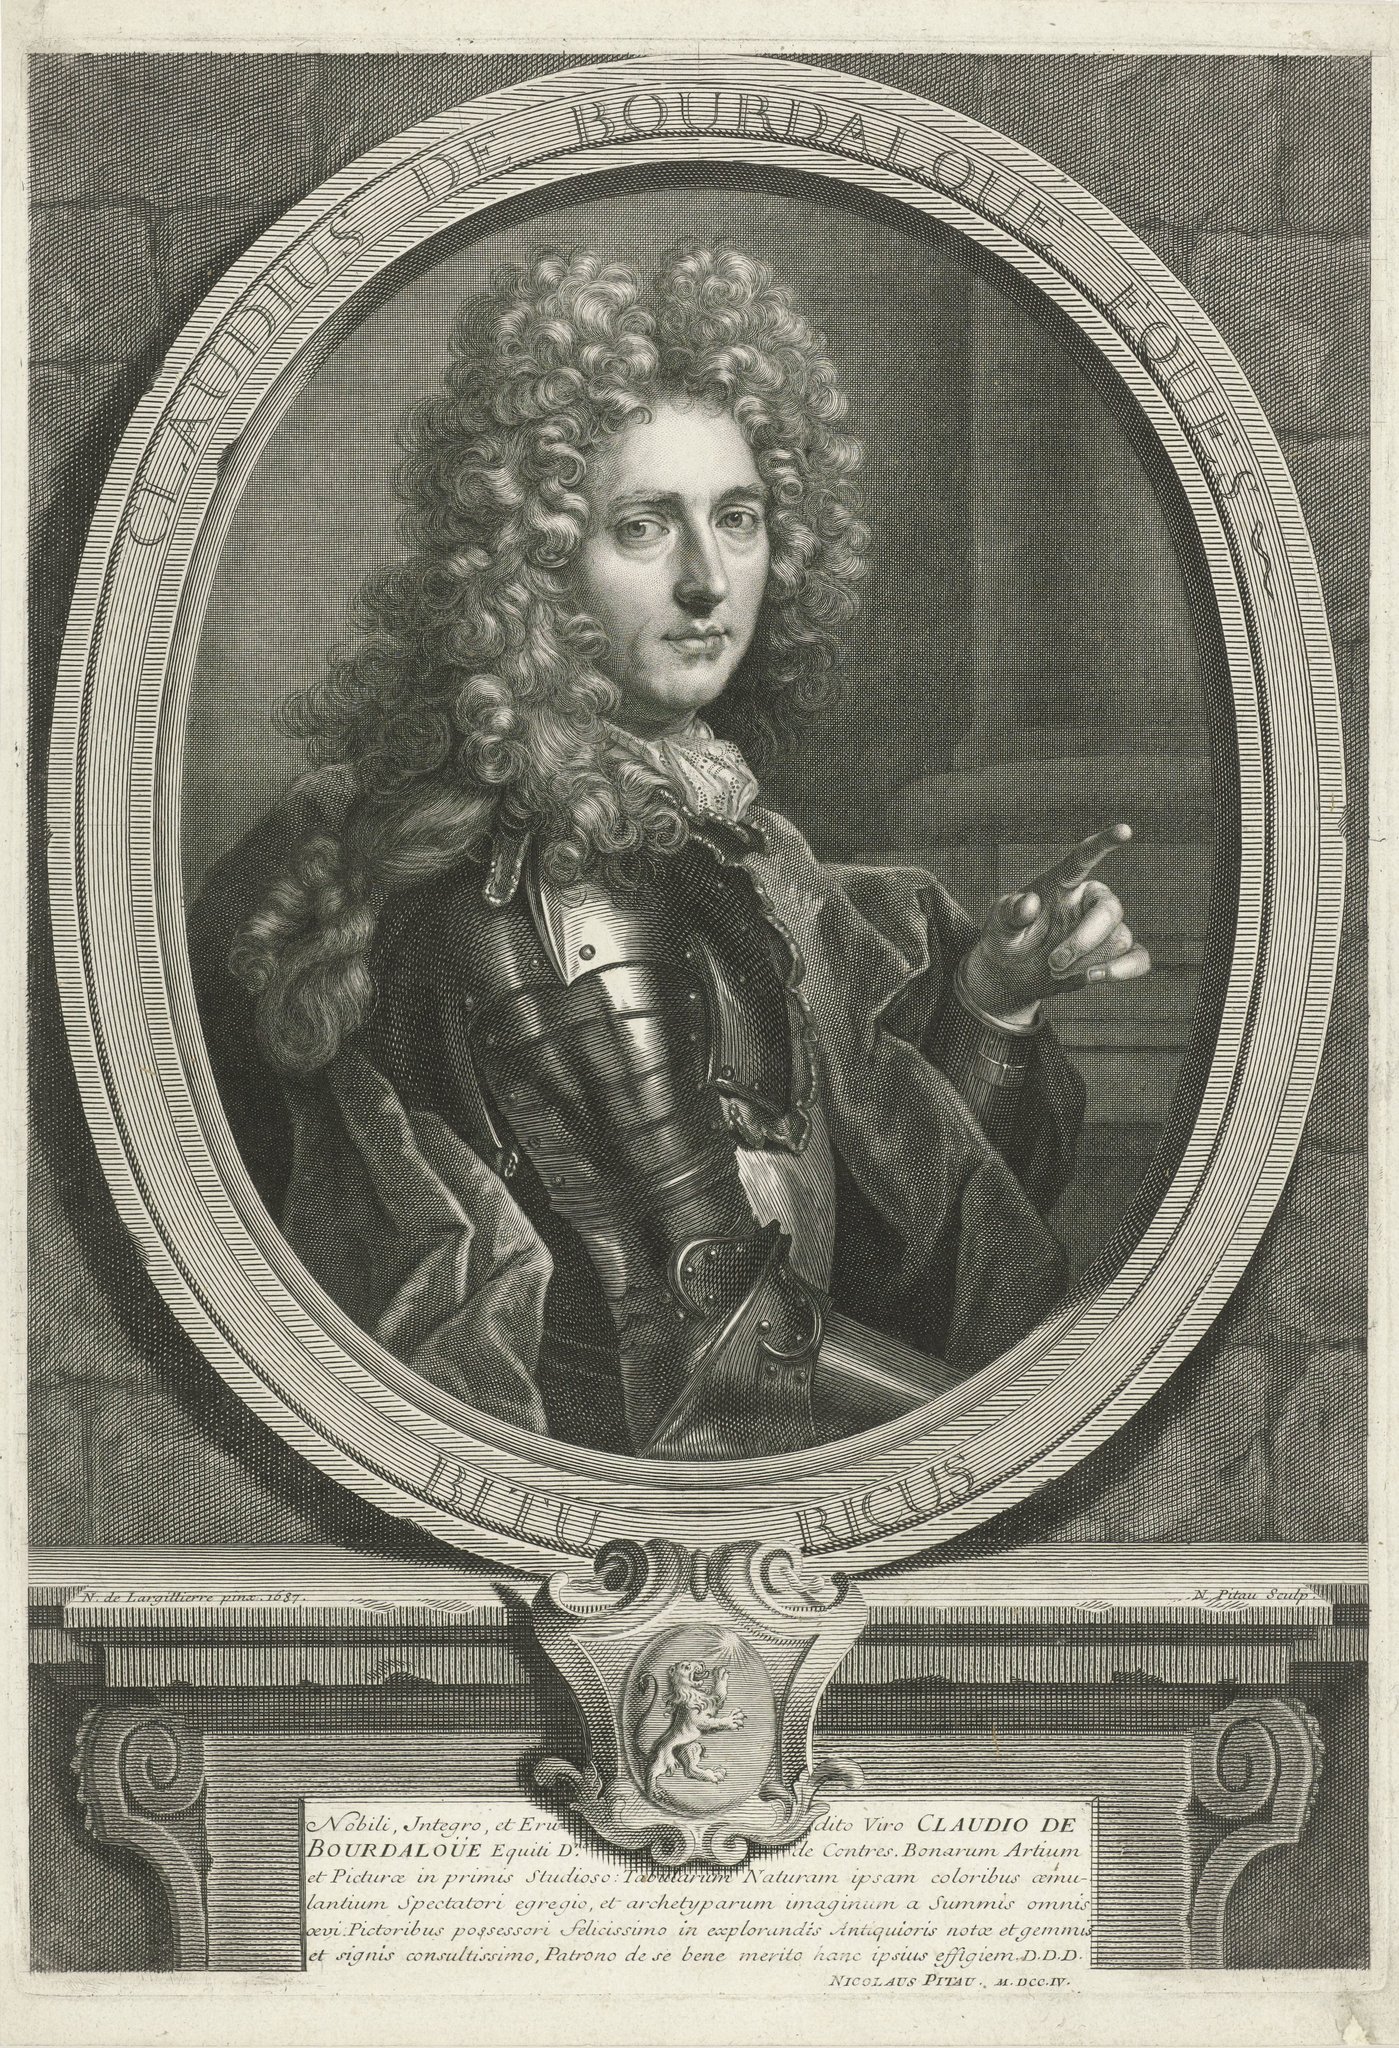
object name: print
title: Portret van Claude de Bourdaloue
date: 1644-1724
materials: paper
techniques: engraving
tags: armour, armorial bearing, heraldry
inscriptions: collector's mark: Lugt 2228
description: Portret van de Franse staatsman Claude de Bourdaloue. Op de piëdestal zijn wapenschild en een zesregelig onderschrift in het Latijn.